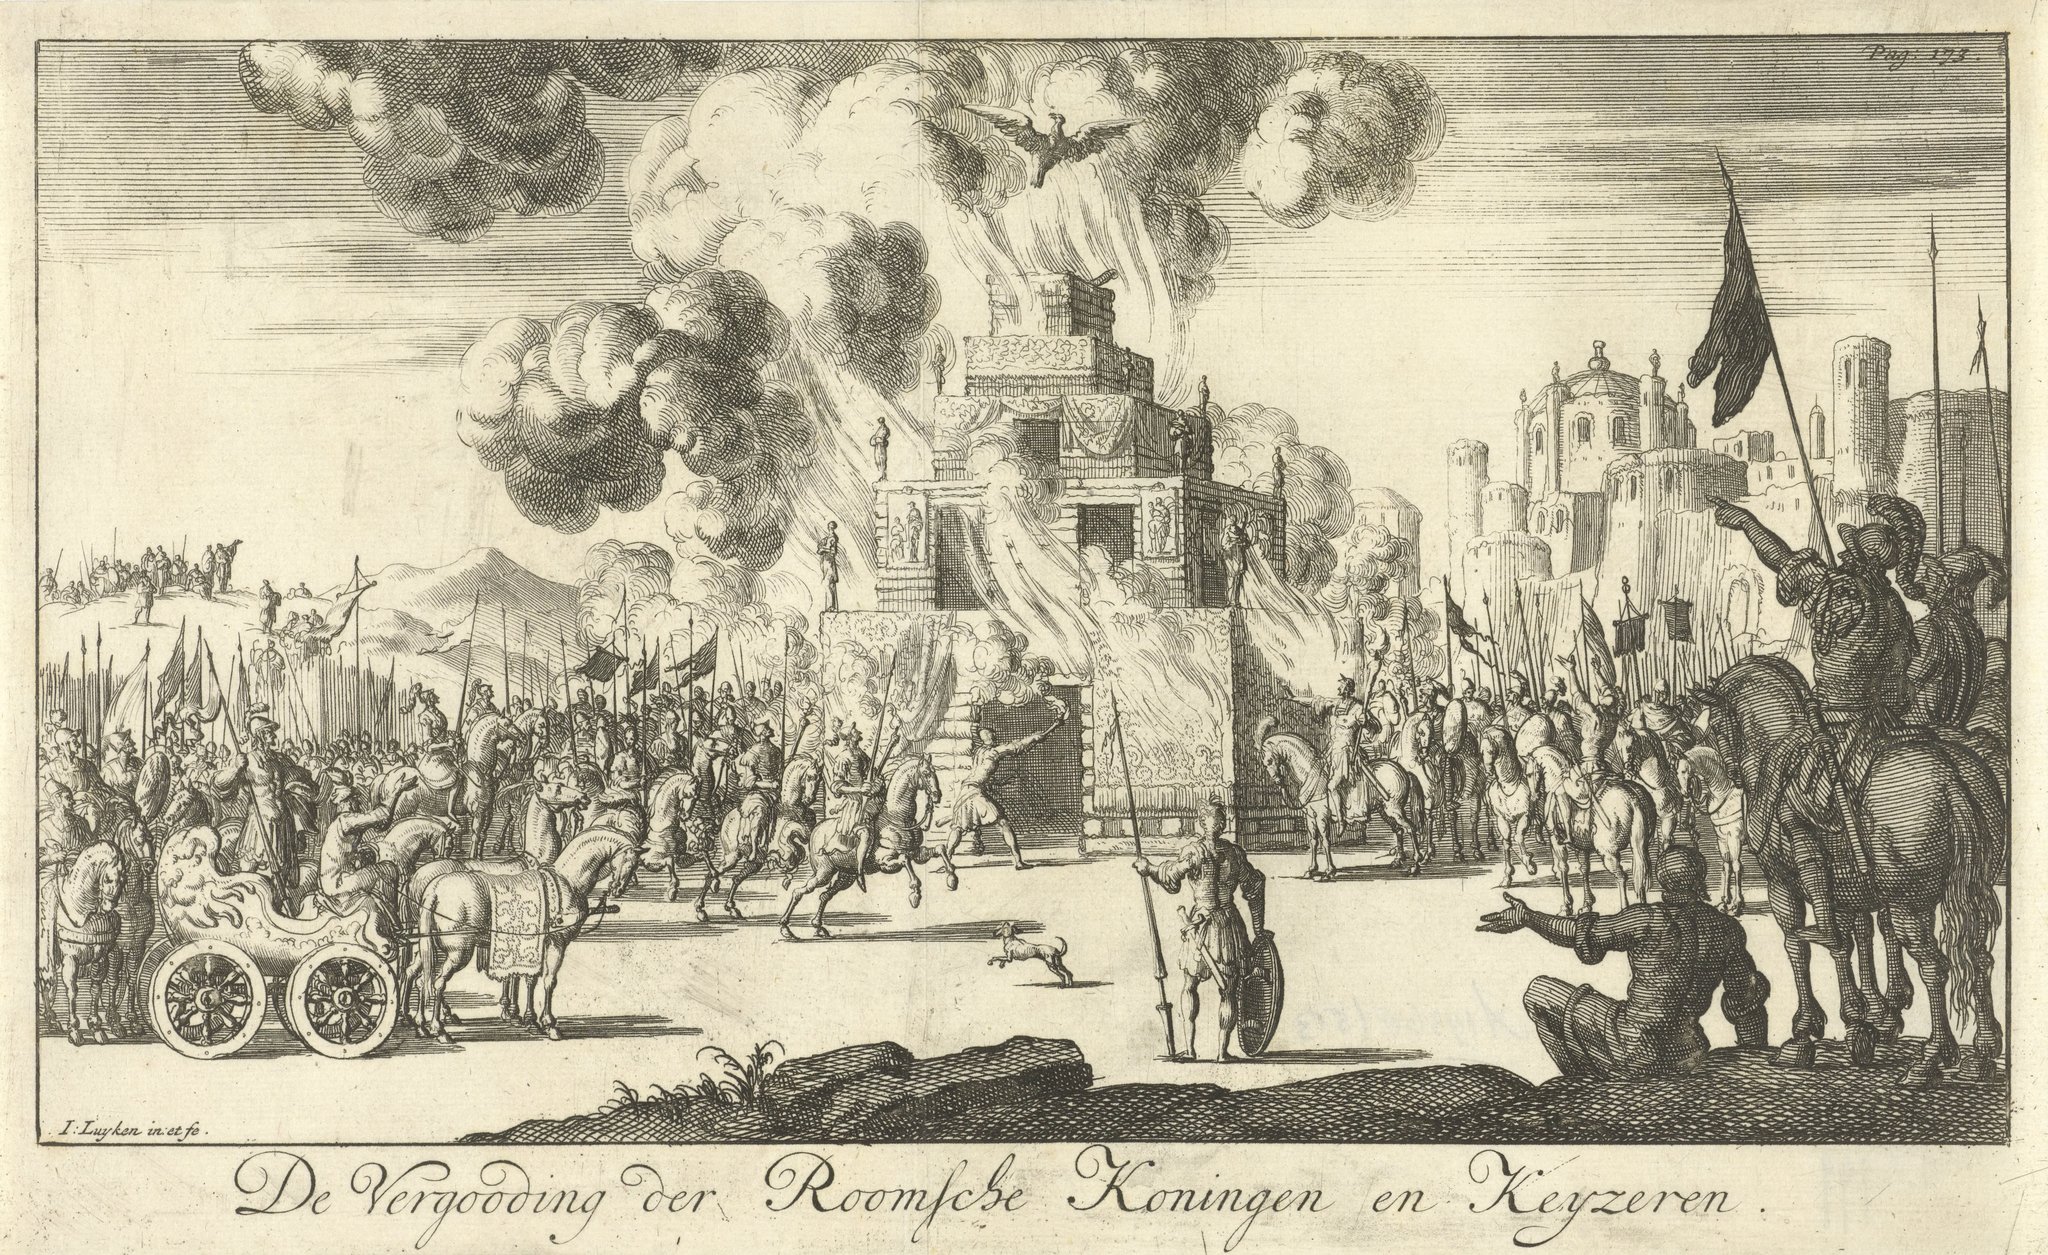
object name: book illustration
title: De Vergooding der Roomsche Koningen en Keyzeren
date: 1686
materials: paper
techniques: etching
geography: amsterdam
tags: ritual practices ~ roman religion, predatory birds: eagle, violent death by burning at the stake; pyre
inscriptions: collector's mark: Lugt 2228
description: Illustratie uit: Aysma, Joannes. Het ryck der goden, onder den eenige waare God, 2 delen. Amsterdam: Timotheus ten Hoorn, 1686, dl. I, p. 173.